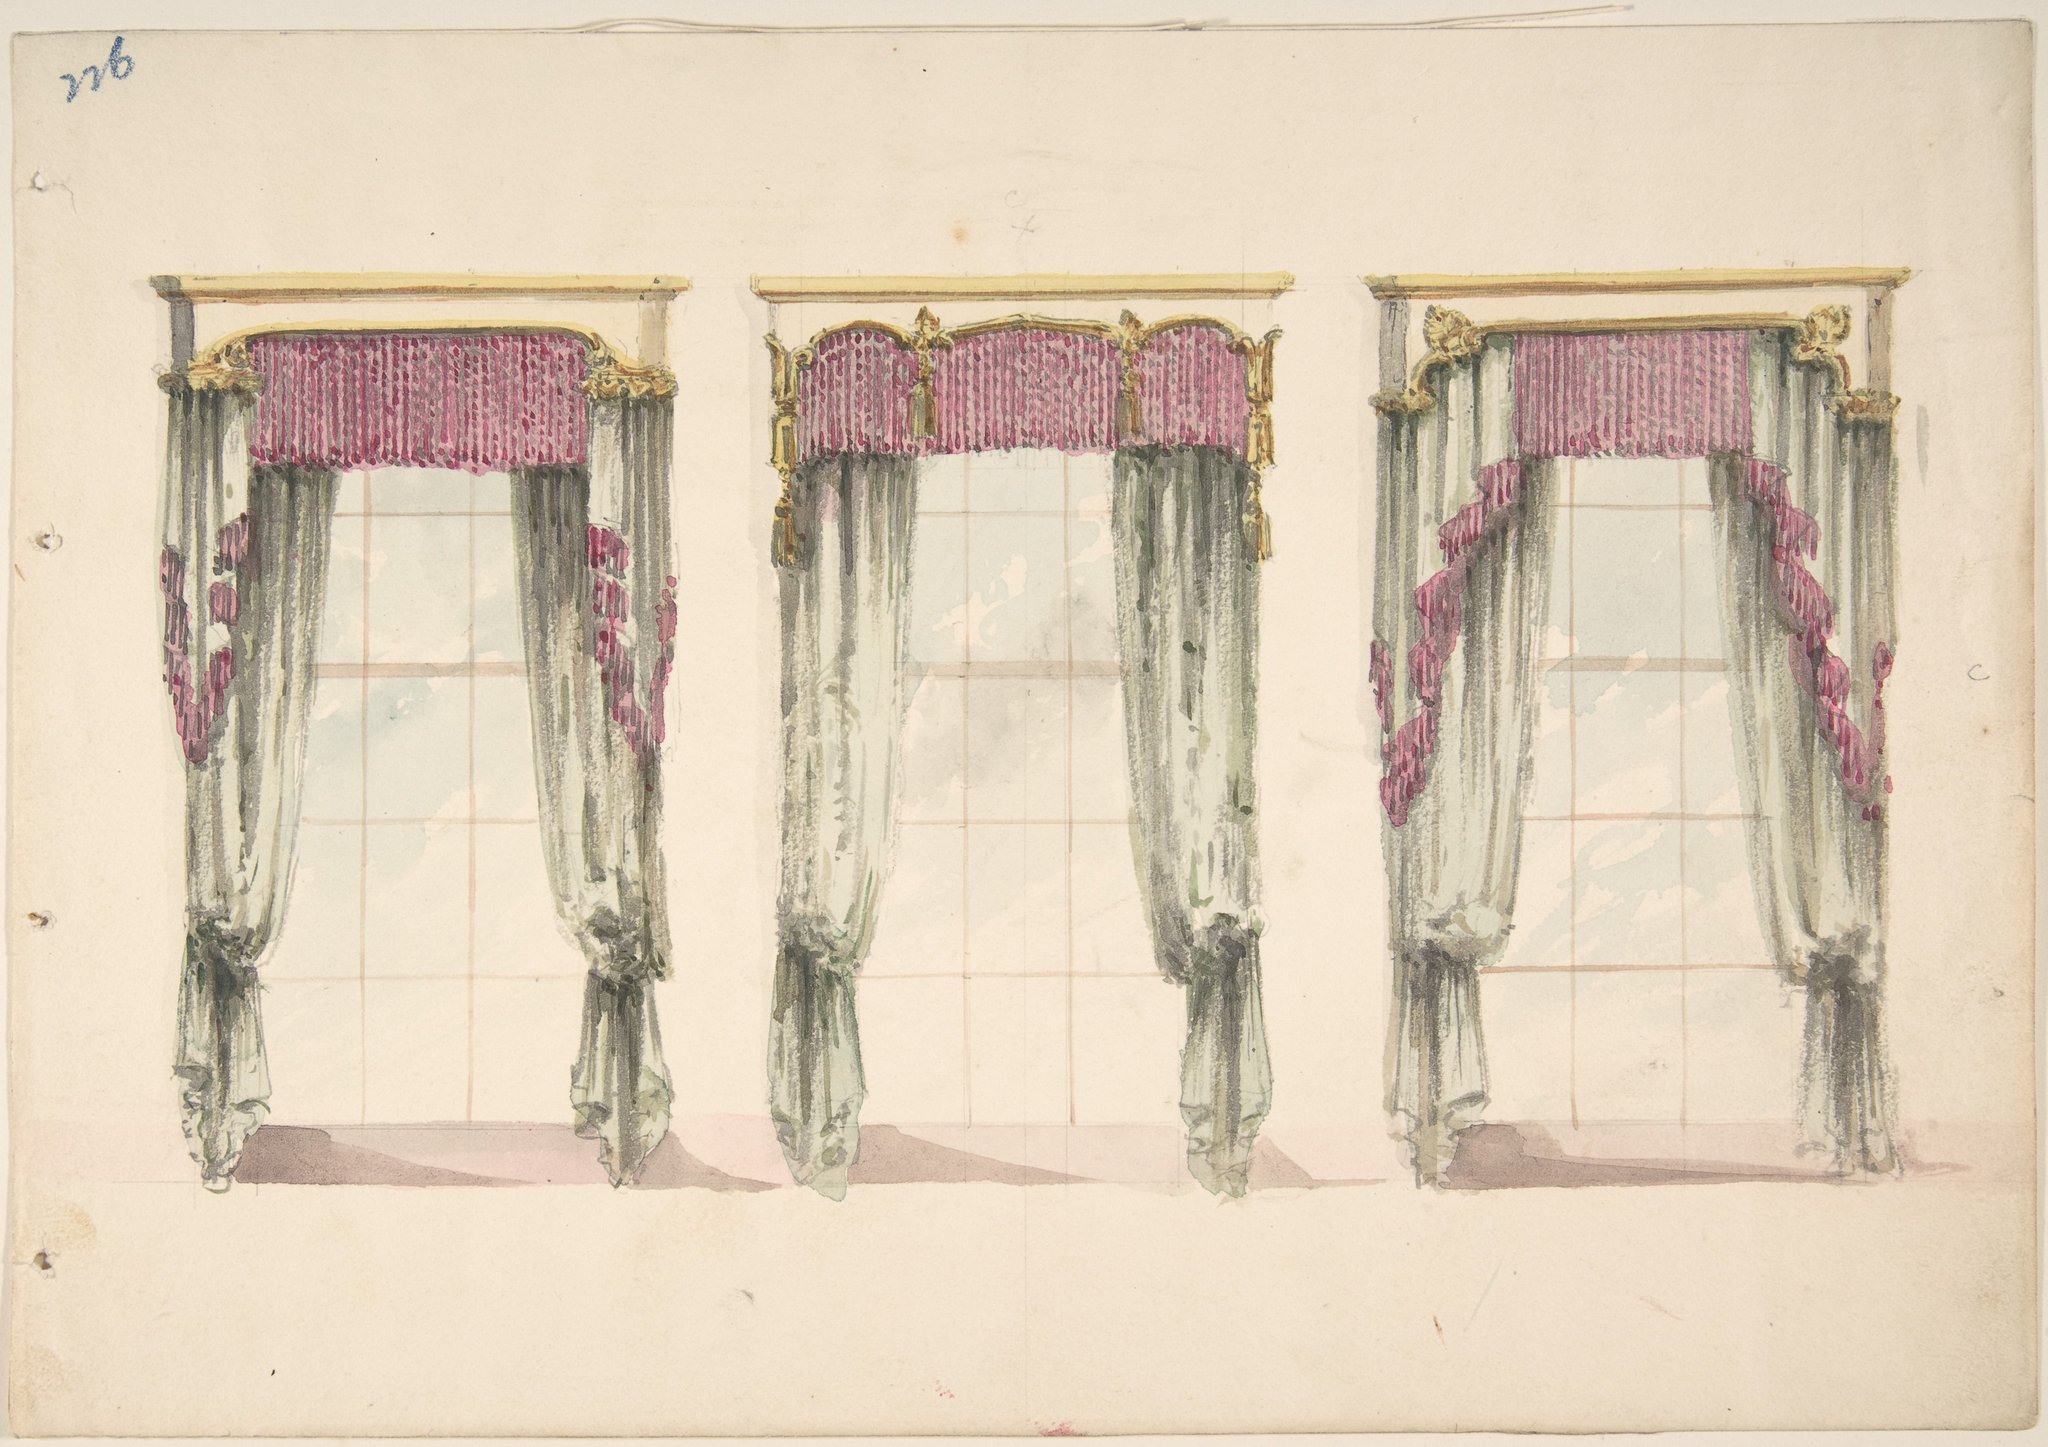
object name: drawing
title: Design for Gray Curtains with Pink Fringes, and White and Gold Pediments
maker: anonymous, british, 19th century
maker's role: artist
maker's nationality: british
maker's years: 1800-1900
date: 1820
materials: ink, watercolor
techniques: brush, pen, wash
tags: curtains